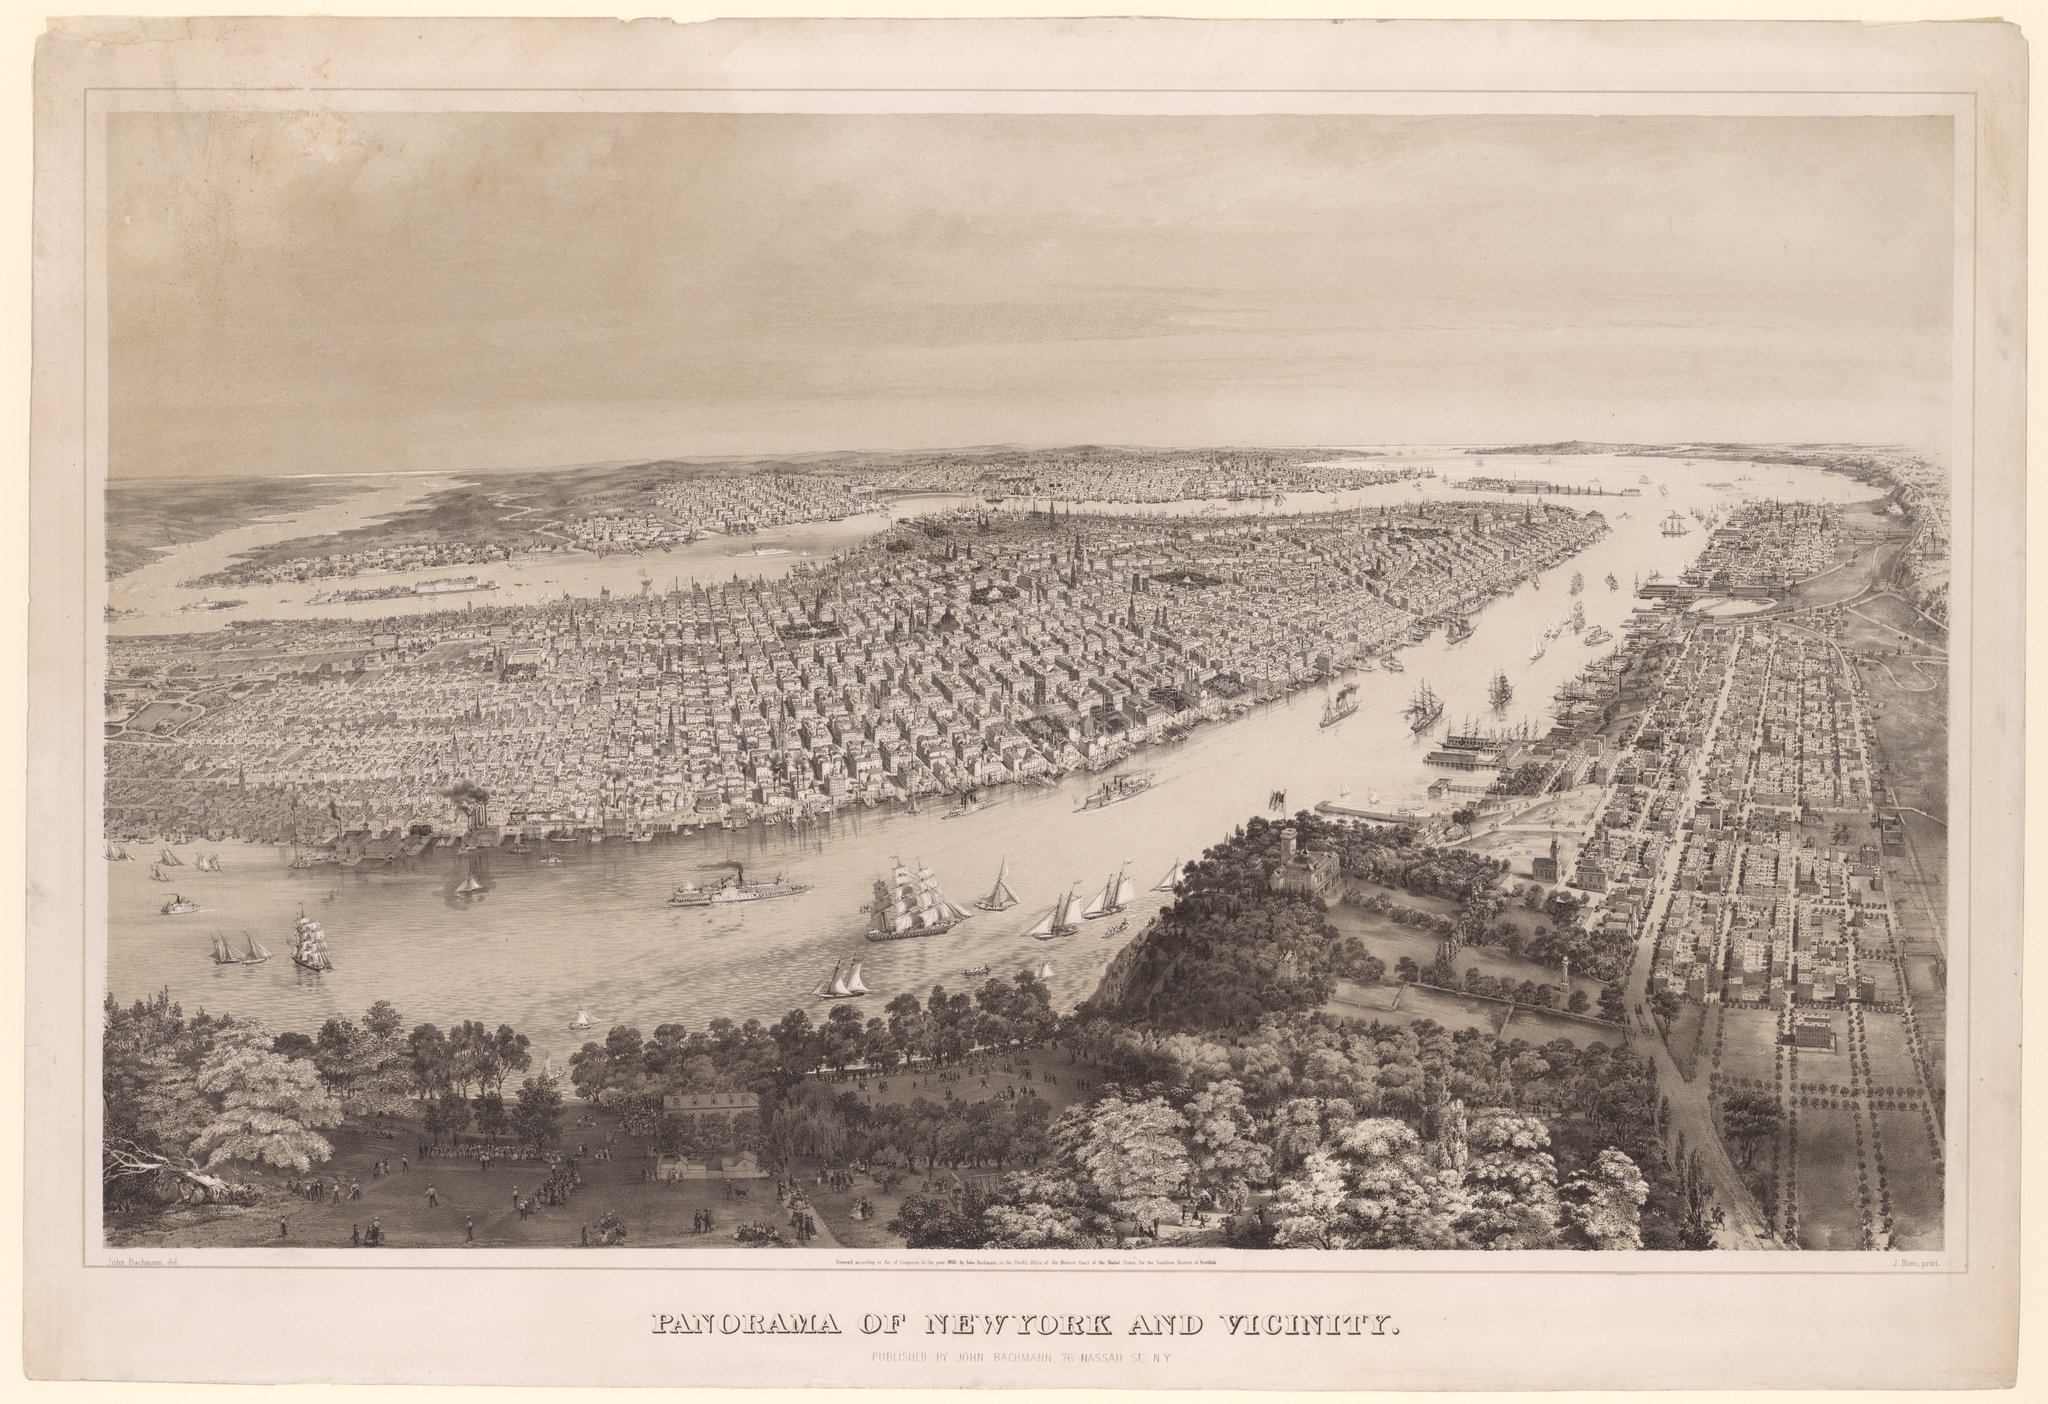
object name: print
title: Panorama of New York and Vicinity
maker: john bachmann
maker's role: artist and publisher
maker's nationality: american, swiss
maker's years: 1814-1896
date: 1866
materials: stone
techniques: lithograph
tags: new york city